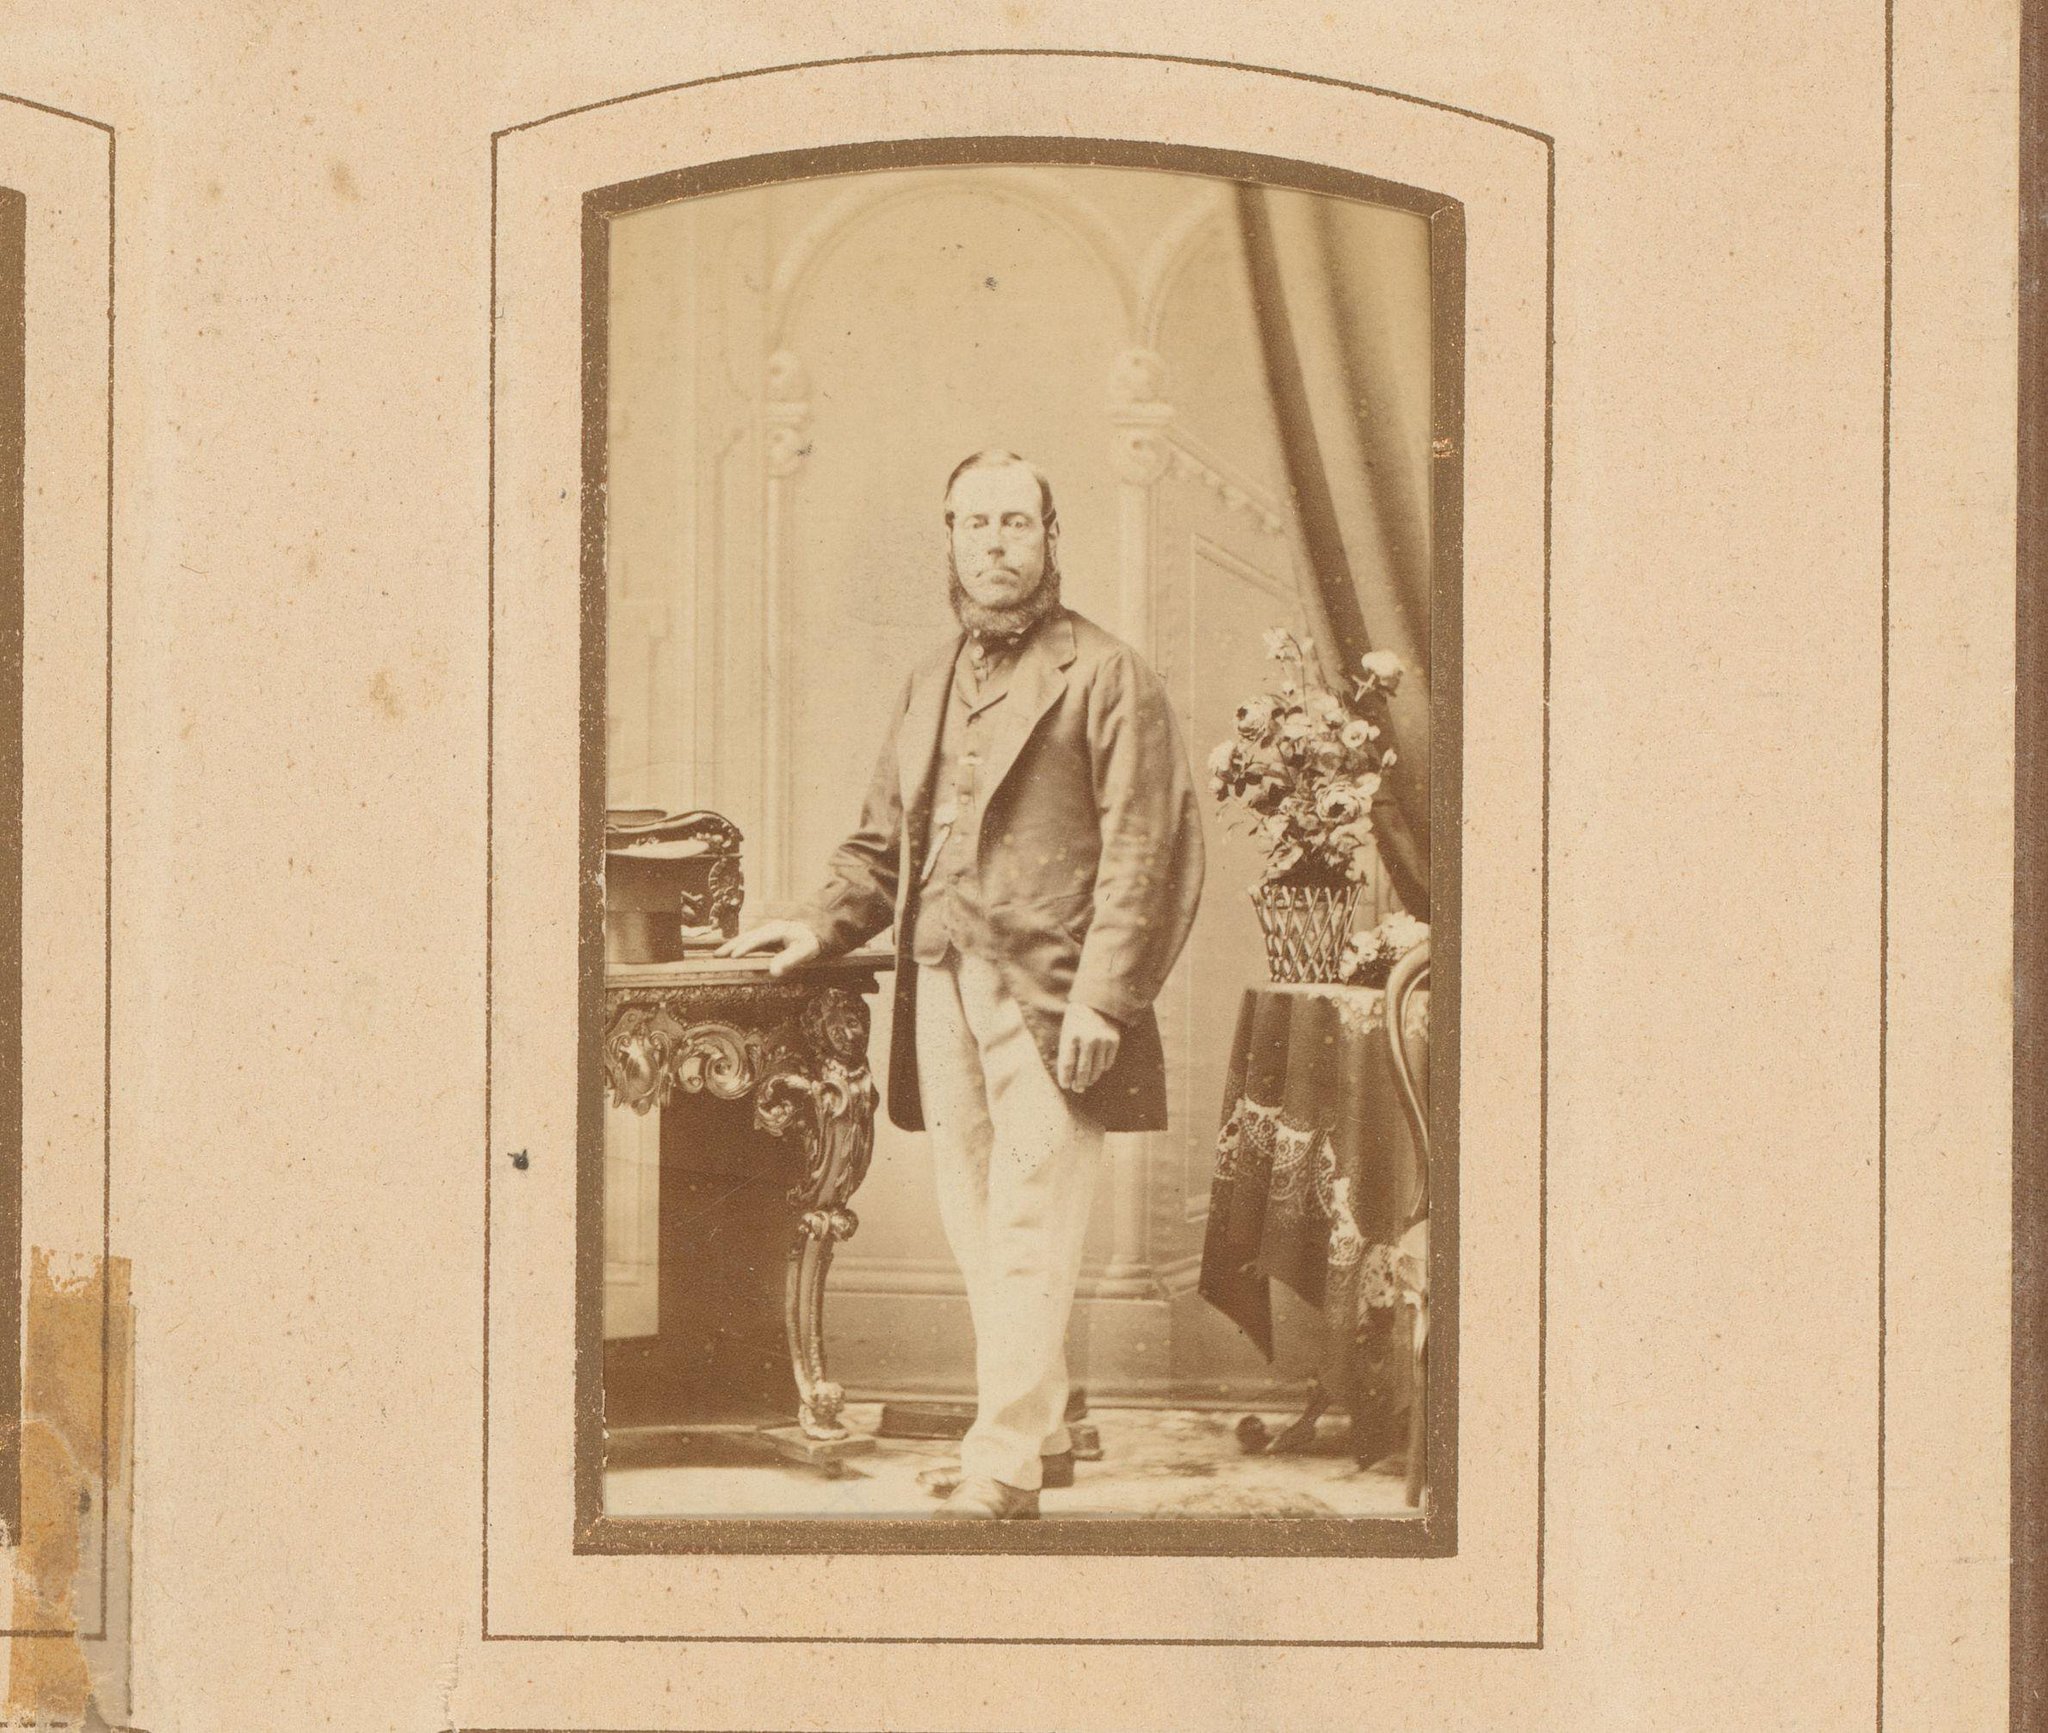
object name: carte de visite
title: Portret van een man met ringbaard, staand bij een tafel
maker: courtenay wynne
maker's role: fotograaf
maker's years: 1841-1886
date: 1860-1900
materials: cardboard, photographic support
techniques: albumen print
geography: brompton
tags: standing figure, historical persons, table, beard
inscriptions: number: ‘11245’, inscription: ‘PHOTOGRAPHED/ BY/ COURTENAY WYNNE/ 267, FULHAM ROAD/ BROMPTON/ COPIES MAY BE HAD’